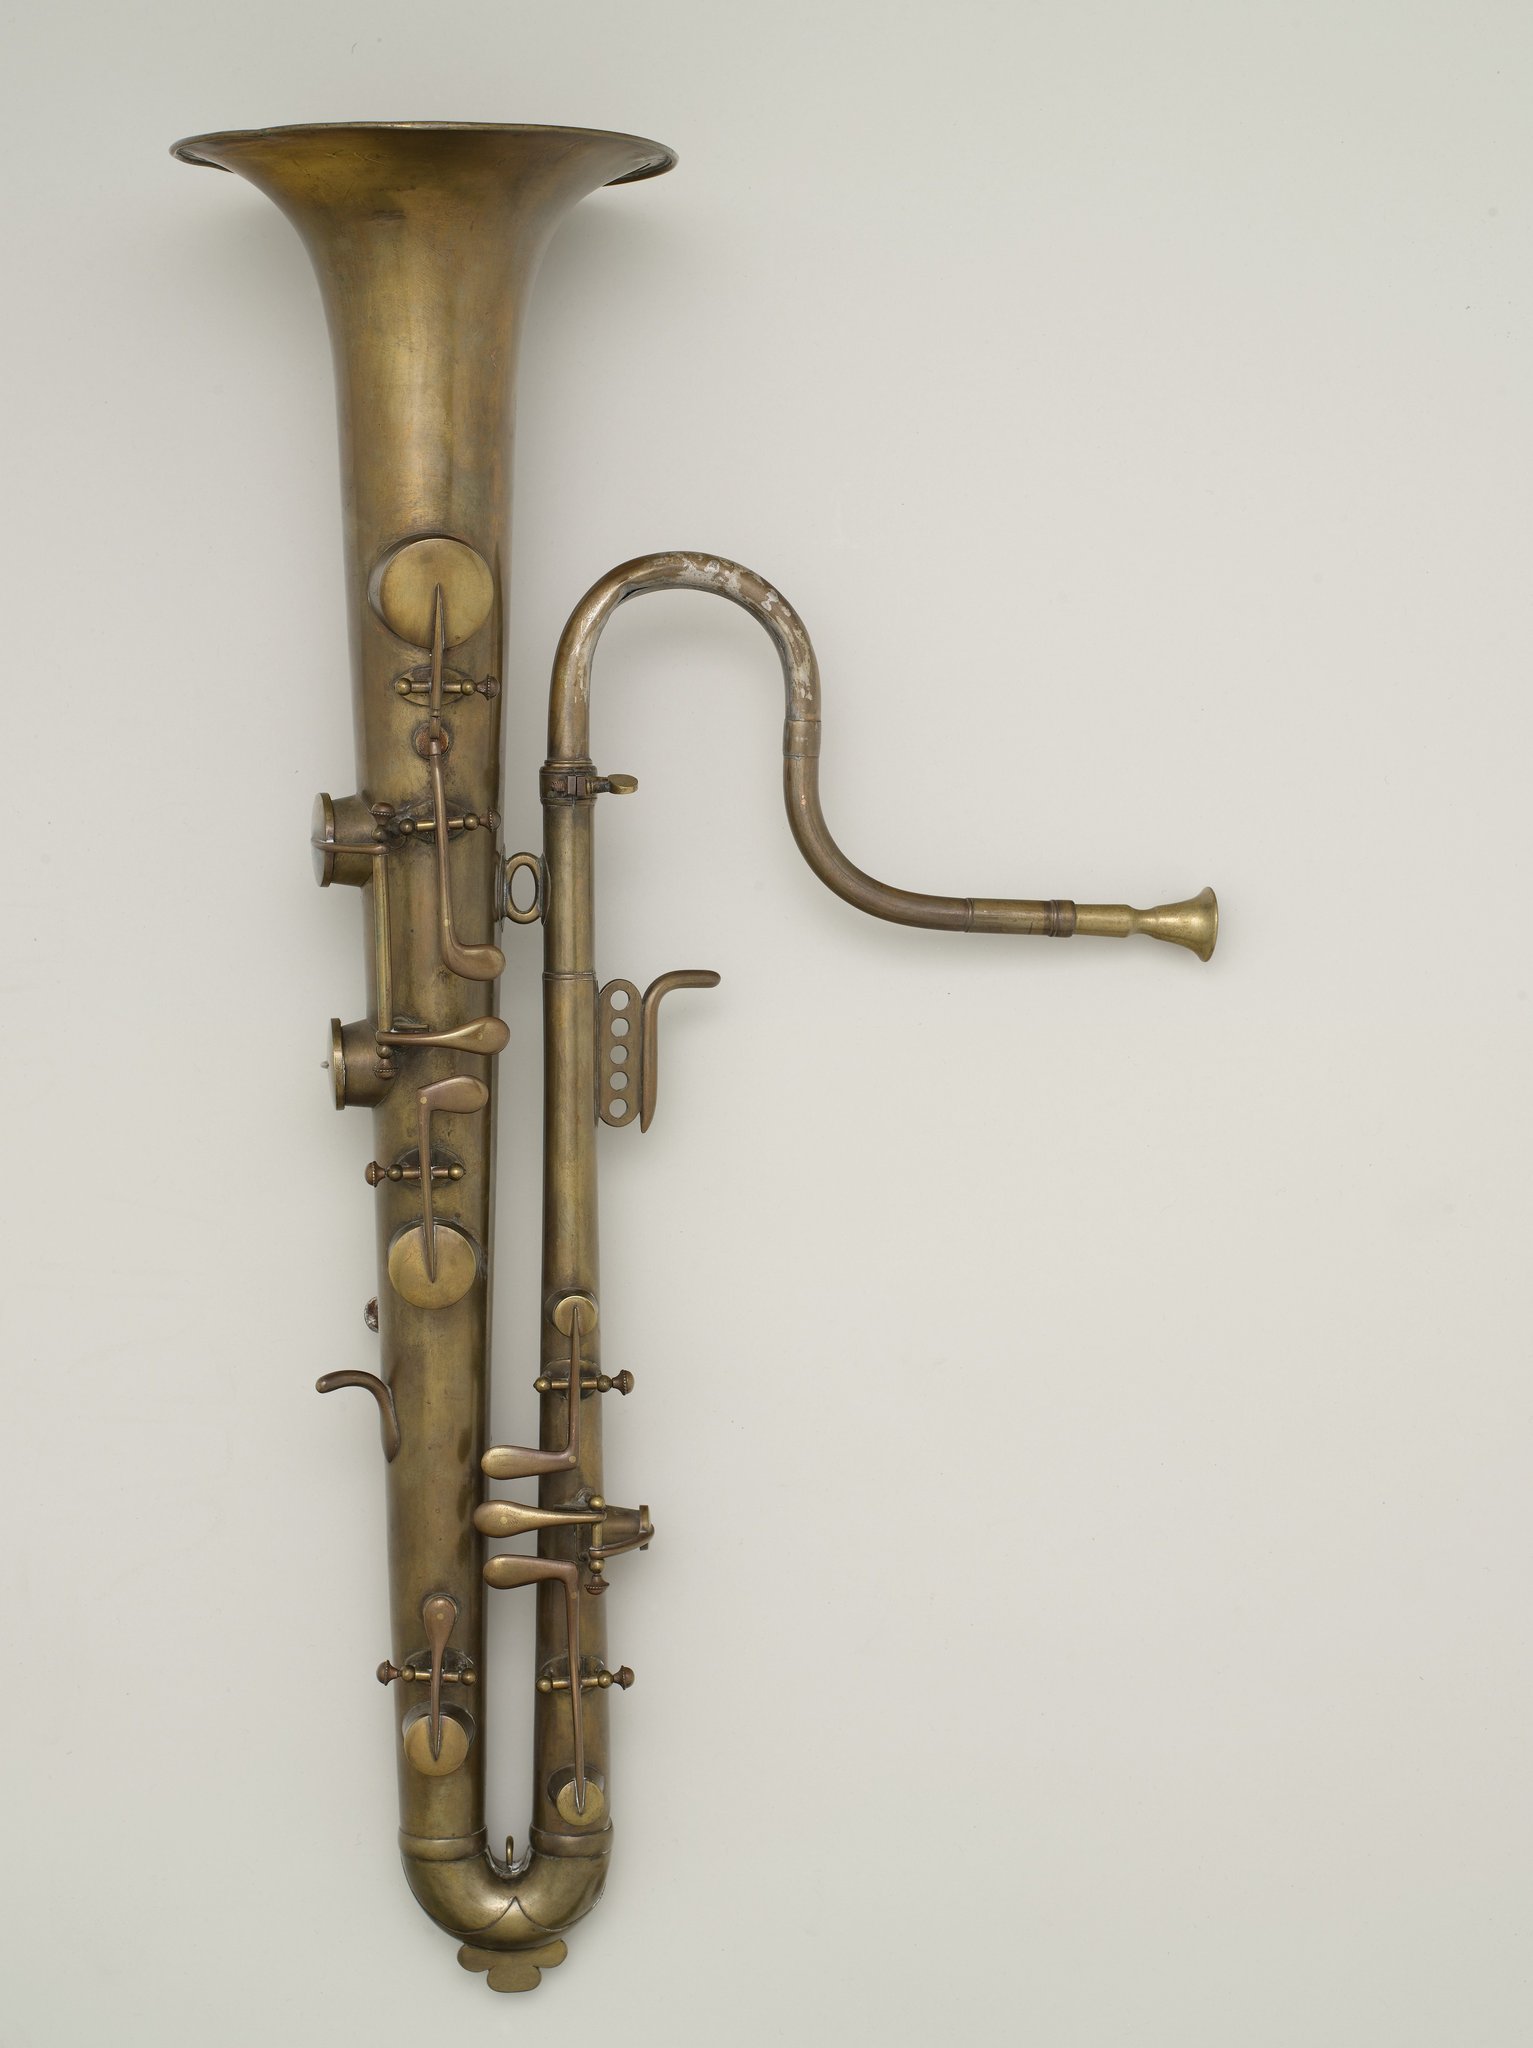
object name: soprano ophicleide in b flat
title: Soprano ophicleide in B-flat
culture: french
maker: adolphe (antoine joseph) sax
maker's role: maker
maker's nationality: belgian, active france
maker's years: 1814-1894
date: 1834-1866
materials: brass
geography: france